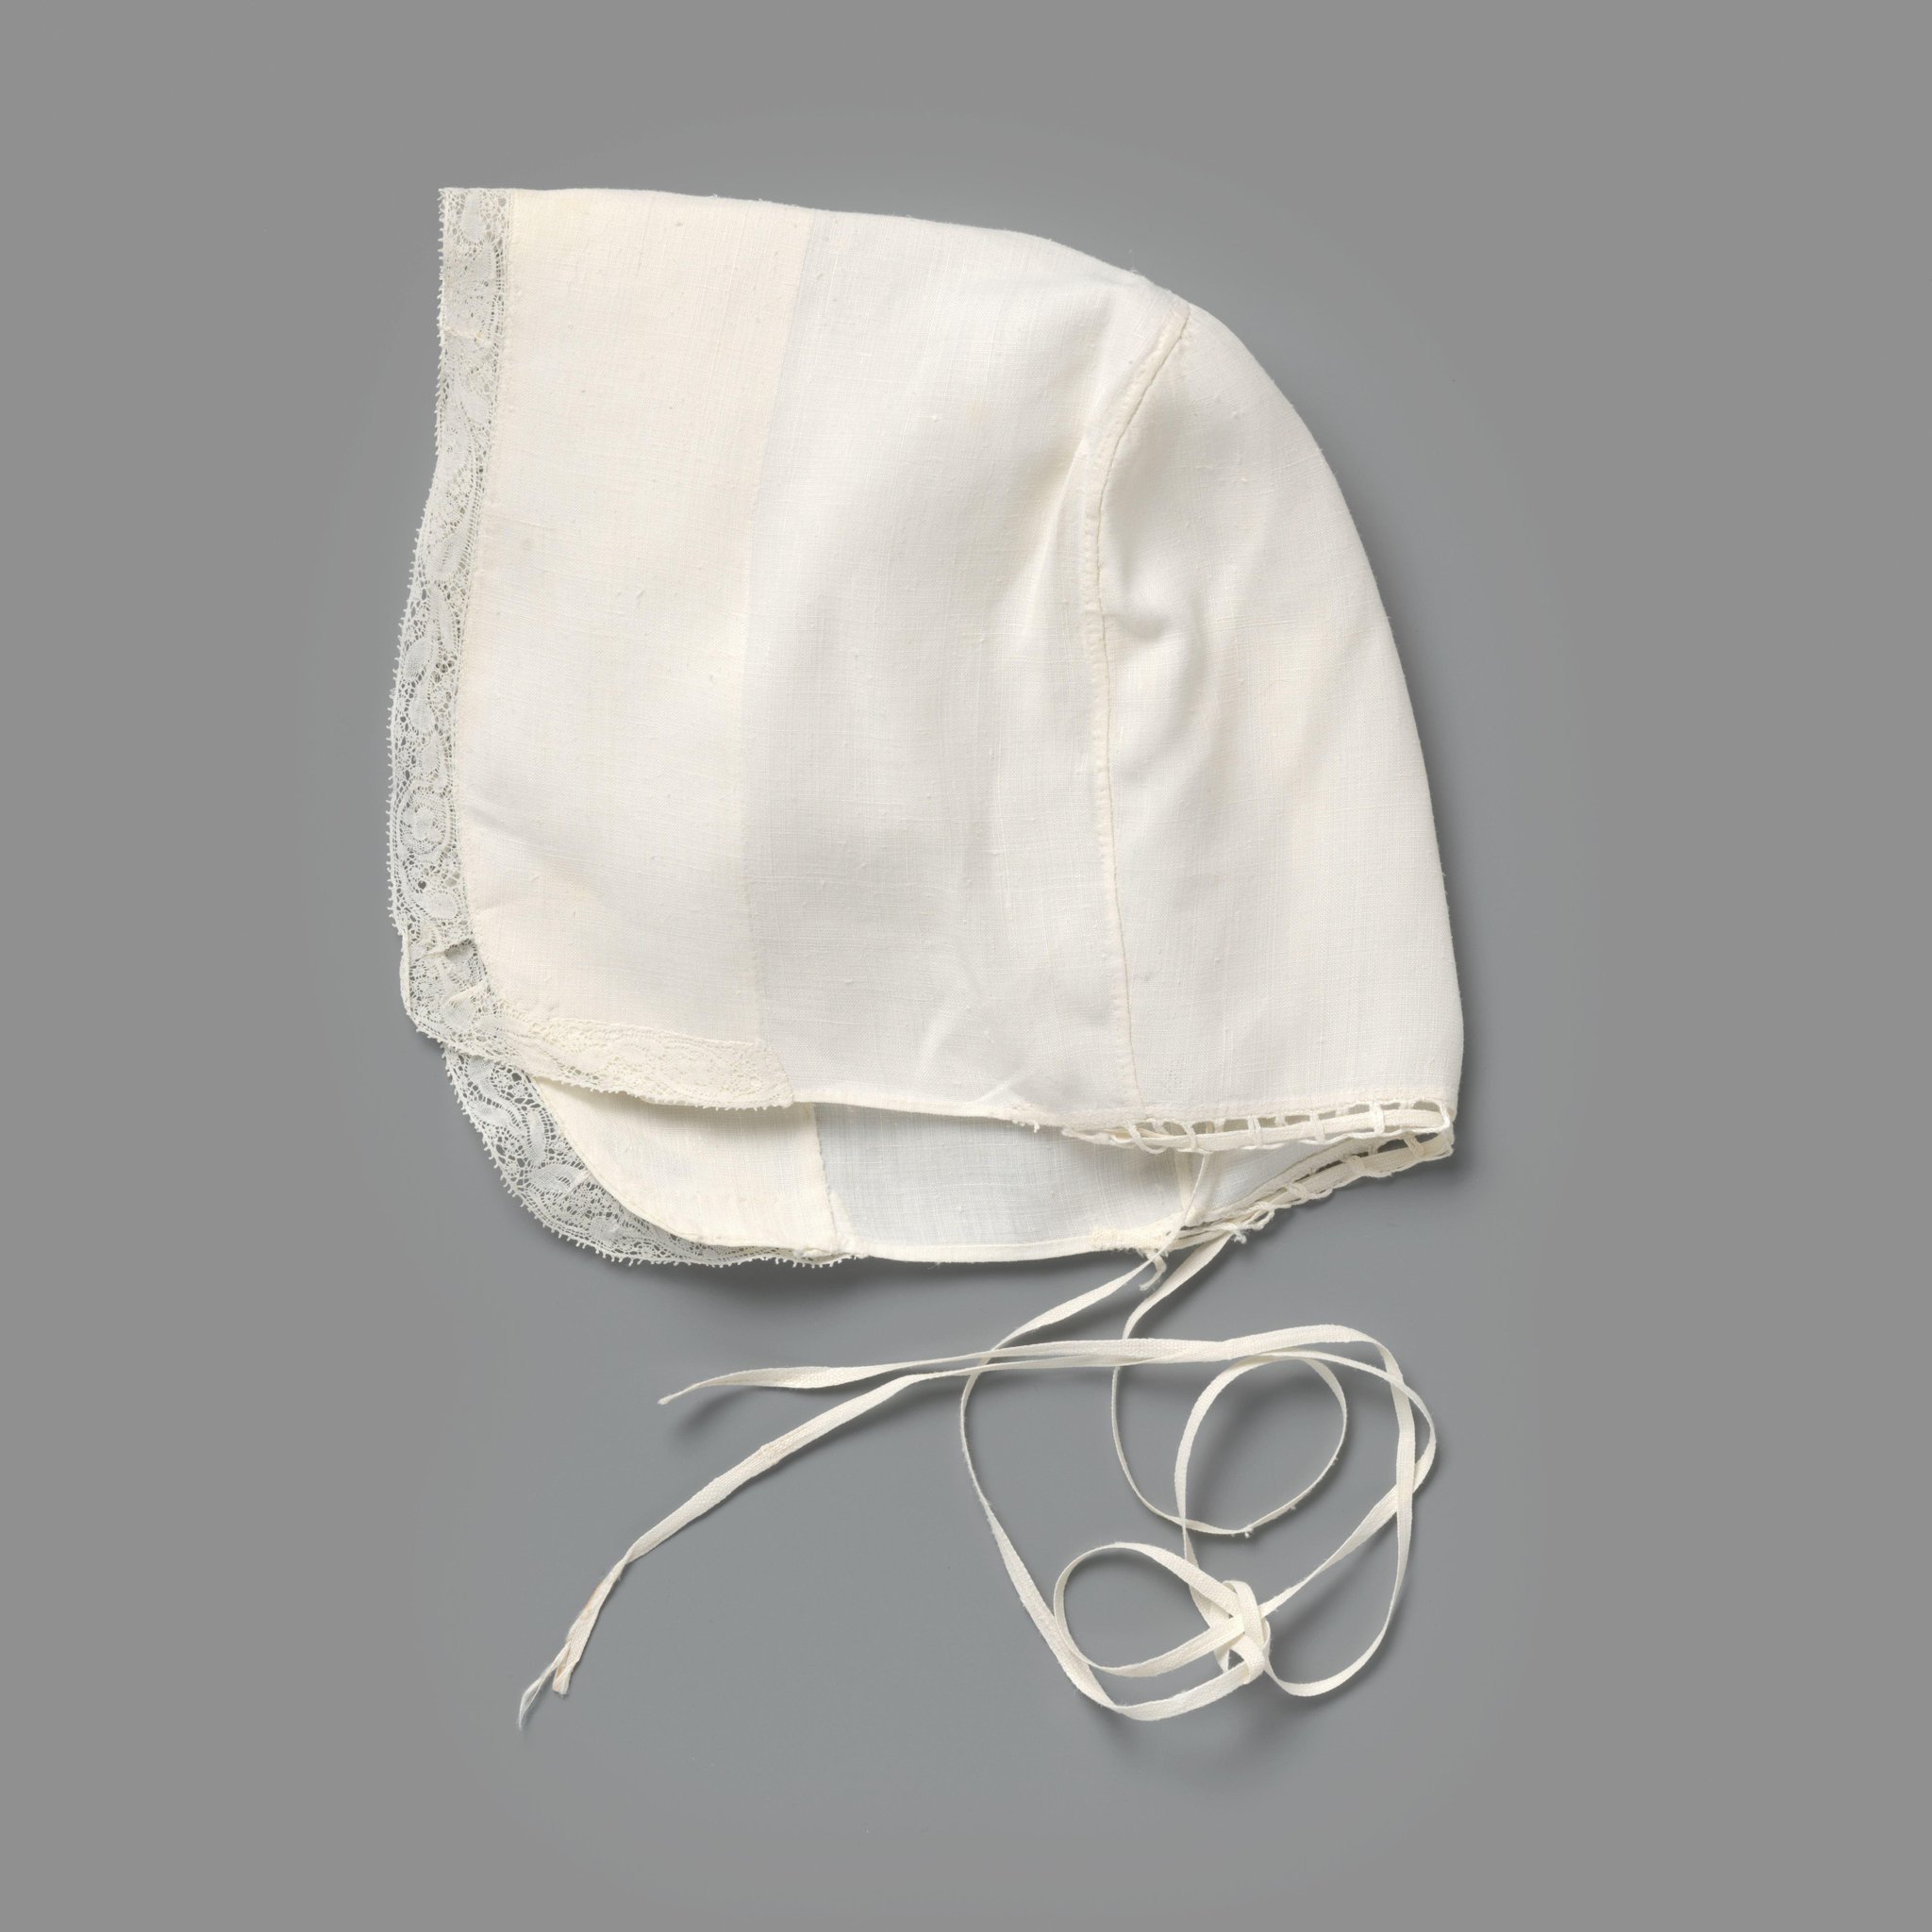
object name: childrenswear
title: Kindermuts van linnen en Binchekant; gemerkt: S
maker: Anonymous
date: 1740-1760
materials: linen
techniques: lace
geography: netherlands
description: Een kindermuts van linnen en kloskant. in drie maten en gemerkt S. Model. Handgenaaid. Brede voorpas met de zoom tot op het midden daarvan. Hoefijzervormige bol. Aangenaalde vetertjes vormen busjes voor het achterste bantje. Slechts met één kinnebandje, dat terzijde wordt gespeld. e. Kant. Binche-kloskant met rechte picotrand, foud van spinnen en een slingerende rank met 'knots'-vormige bladeren.